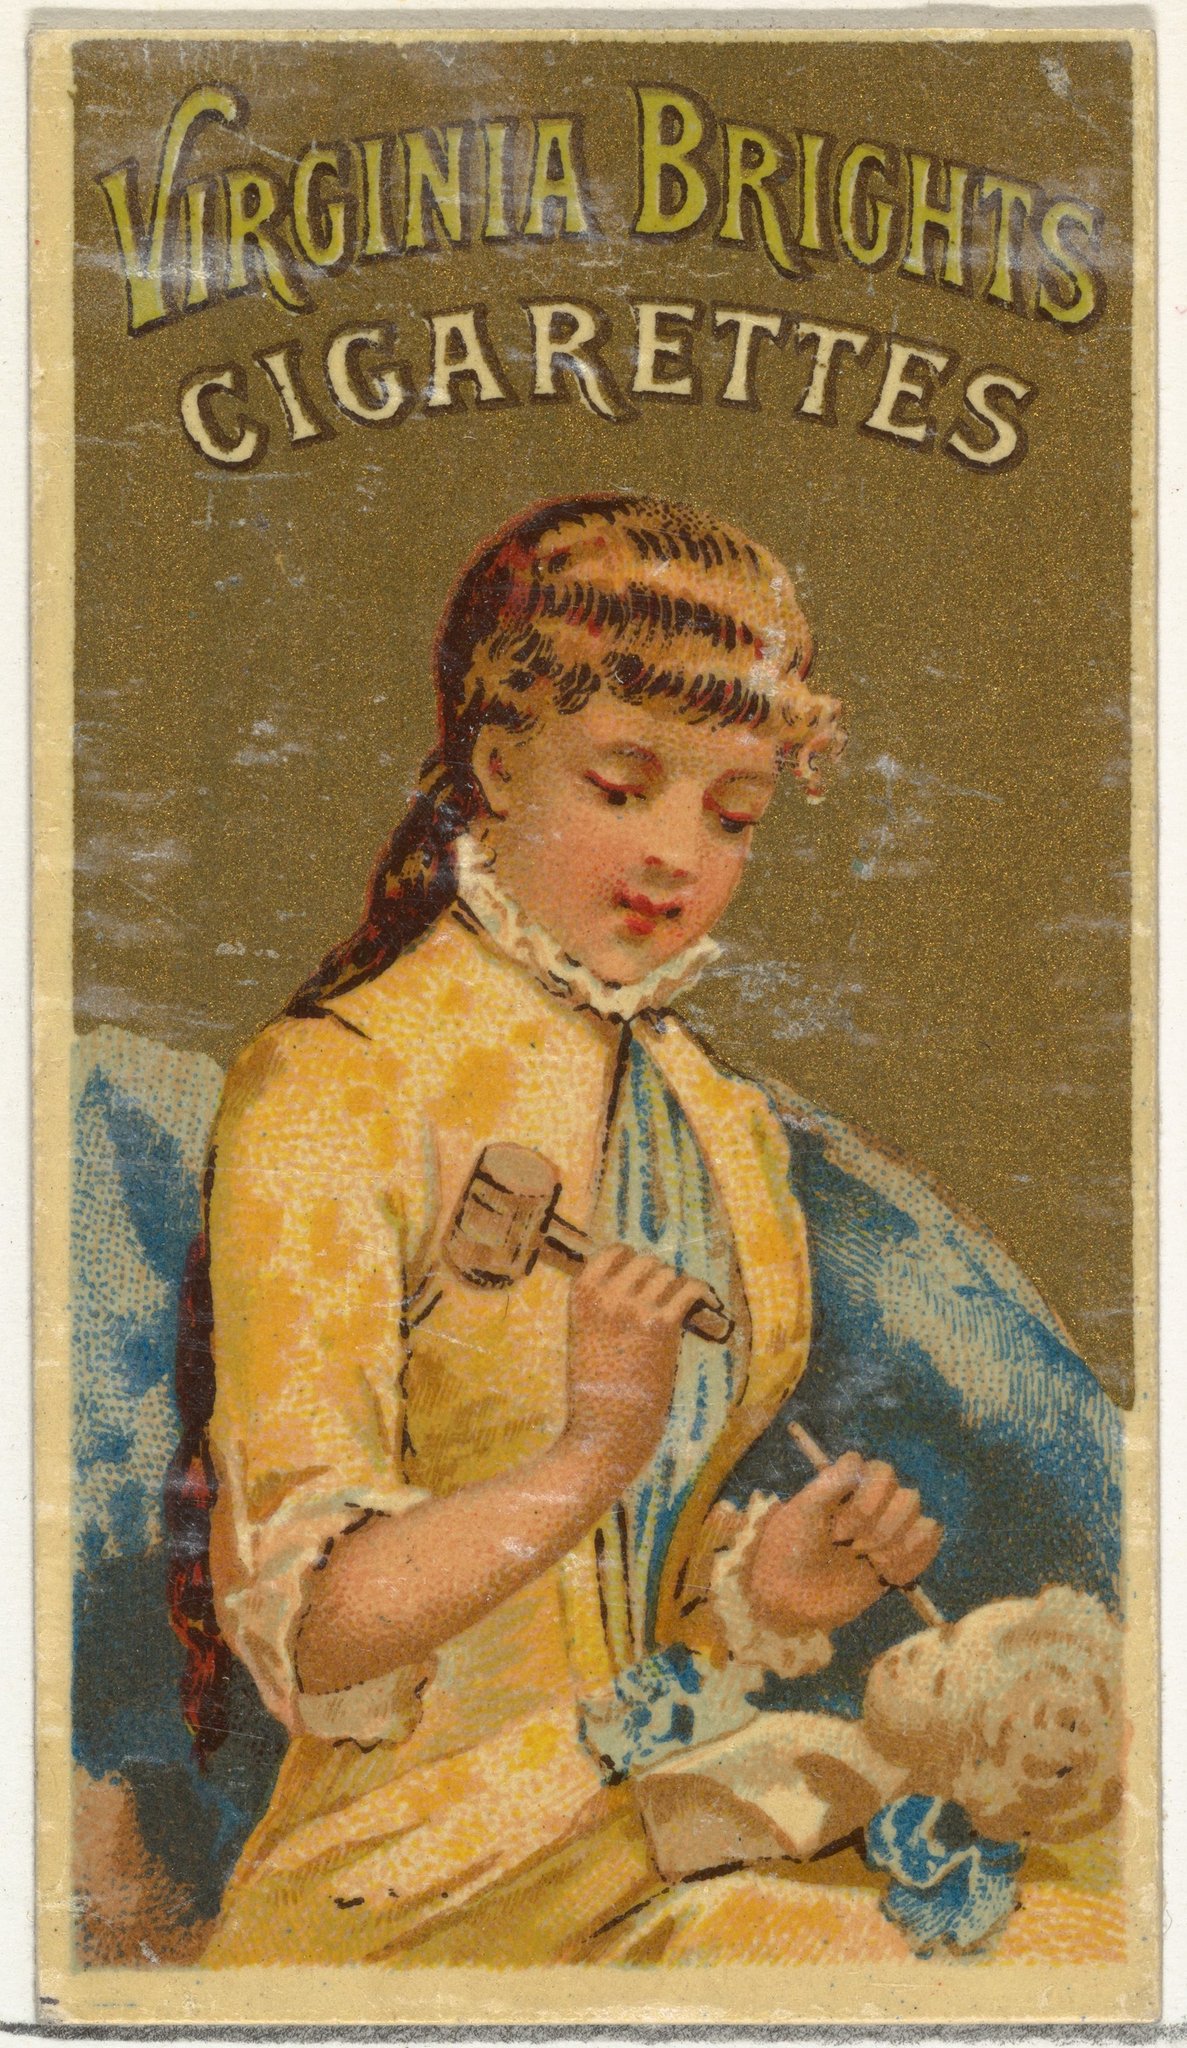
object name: print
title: From the Girls and Children series (N64) promoting Virginia Brights Cigarettes for Allen & Ginter brand tobacco products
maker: allen & ginter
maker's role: publisher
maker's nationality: american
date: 1886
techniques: color lithograph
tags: girls